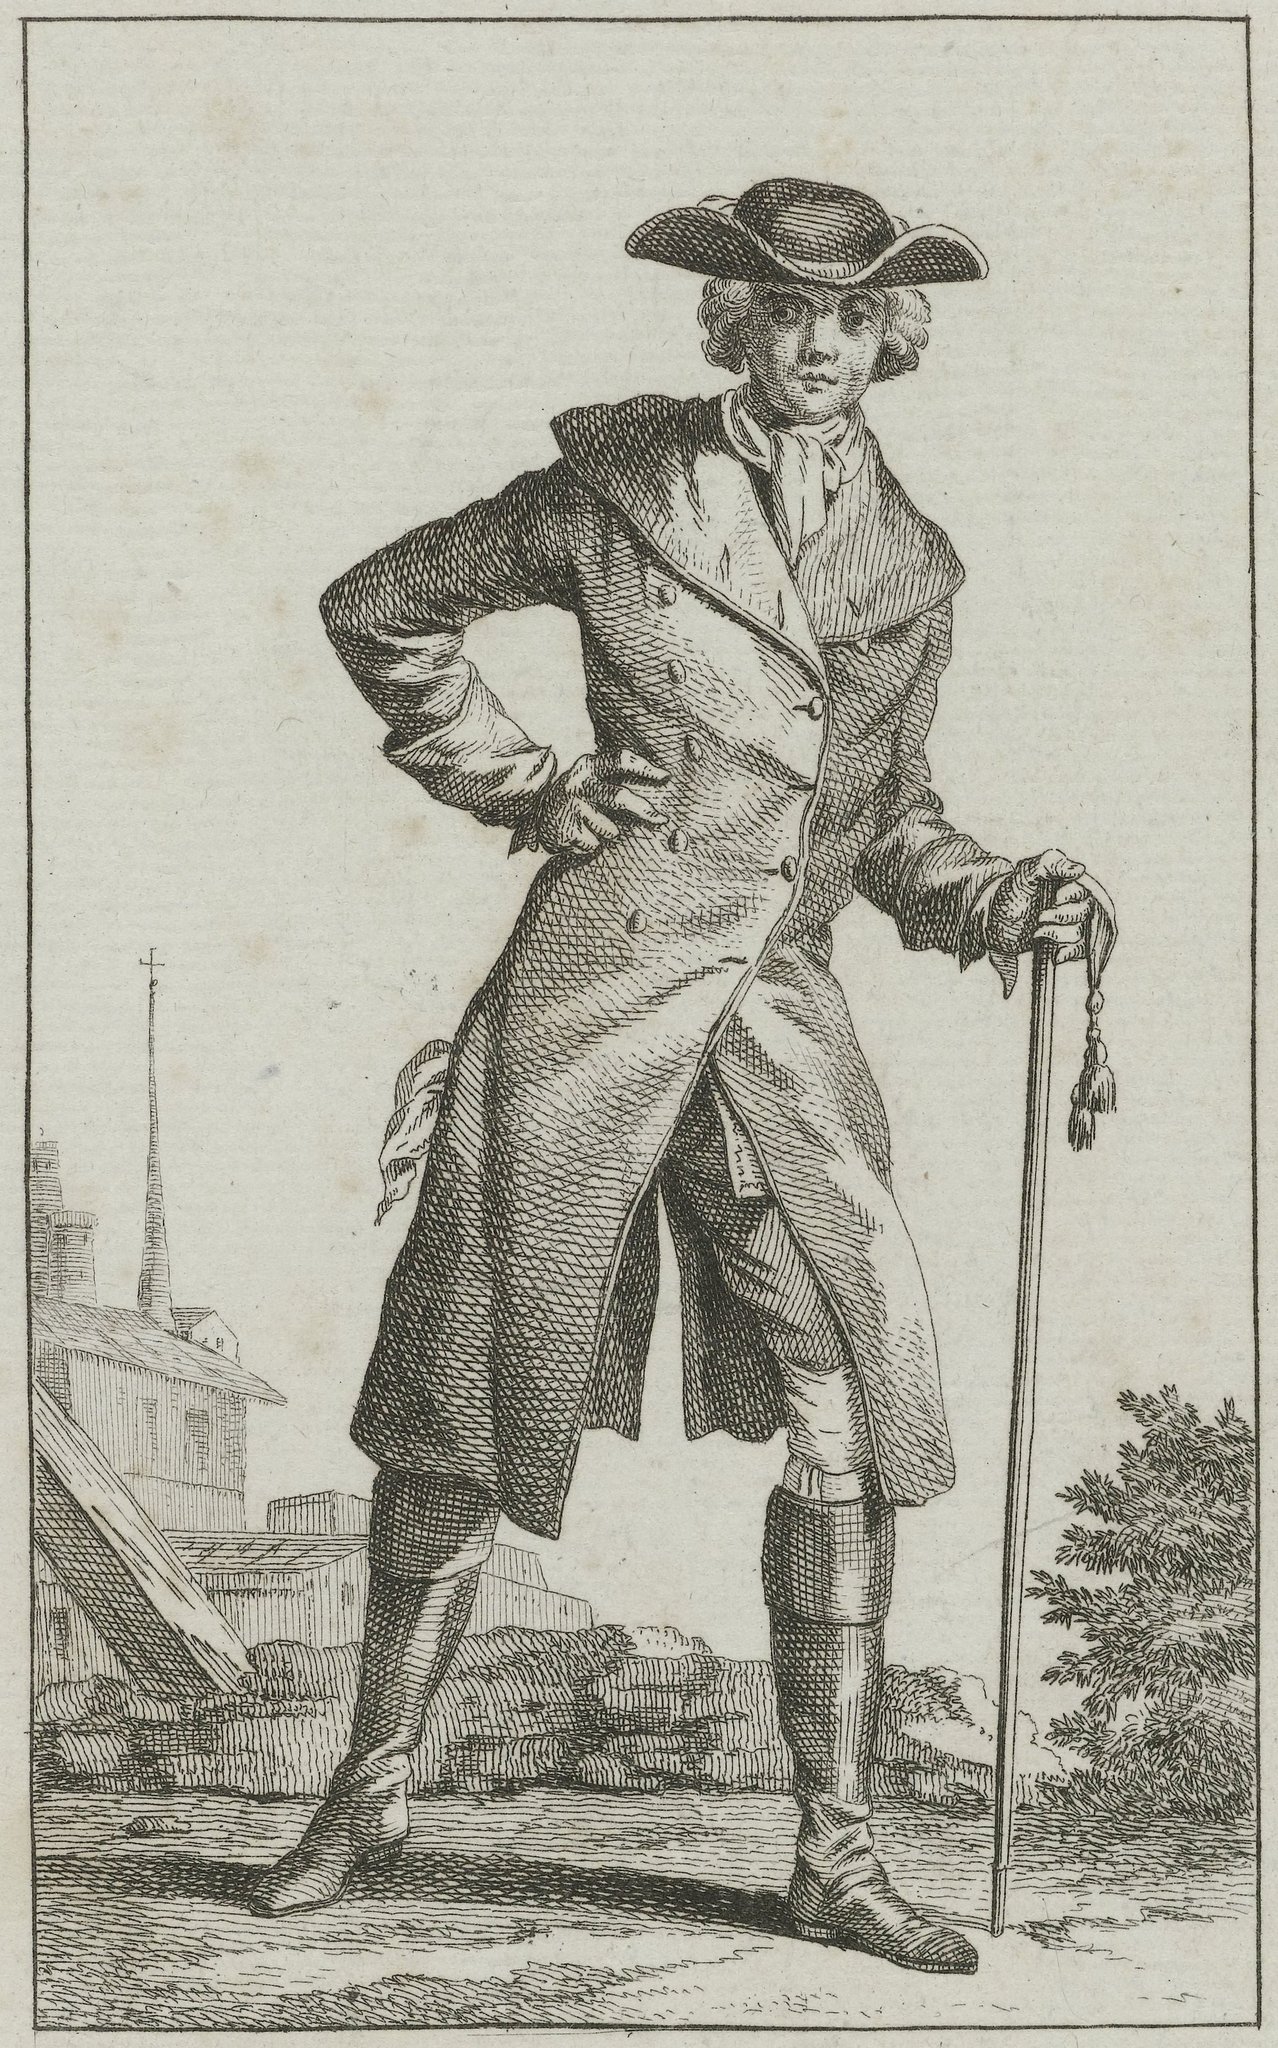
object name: costume print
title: Suite des Nouvelles Modes Françaises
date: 1778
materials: paper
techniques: engraving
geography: paris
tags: neck-gear ~ clothing (cravat) (+ men's clothes), coat (frac) (+ men's clothes), head-gear: hat (+ men's clothes), fashion plates, clothing for the upper part of the body (+ men's clothes), hairdresser, boots (+ men's clothes), walking-stick, staff, cane (+ men's clothes)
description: Man van voren gezien, rechter hand in de zij, gekleed in frak met een dubbele rij knopen (waarvan slechts twee in het knoopsgat zitten), kniebroek en laarzen. Cravate om de hals. Hoed met brede rand. Zijn linkerhand rust op een wandelstok met lint en kwasten. No. 7 uit een reeks van 24 kostuumprenten getiteld 'Suite des Nouvelles Modes Françaises depuis 1778 jusqu'à ce jour, dessiné d'après nature par C.L. Desrais.' Zonder legenda. De uitgave mét legenda meldt dat de man een elegante dameskapper is die zich naar de grand Salon begeeft.